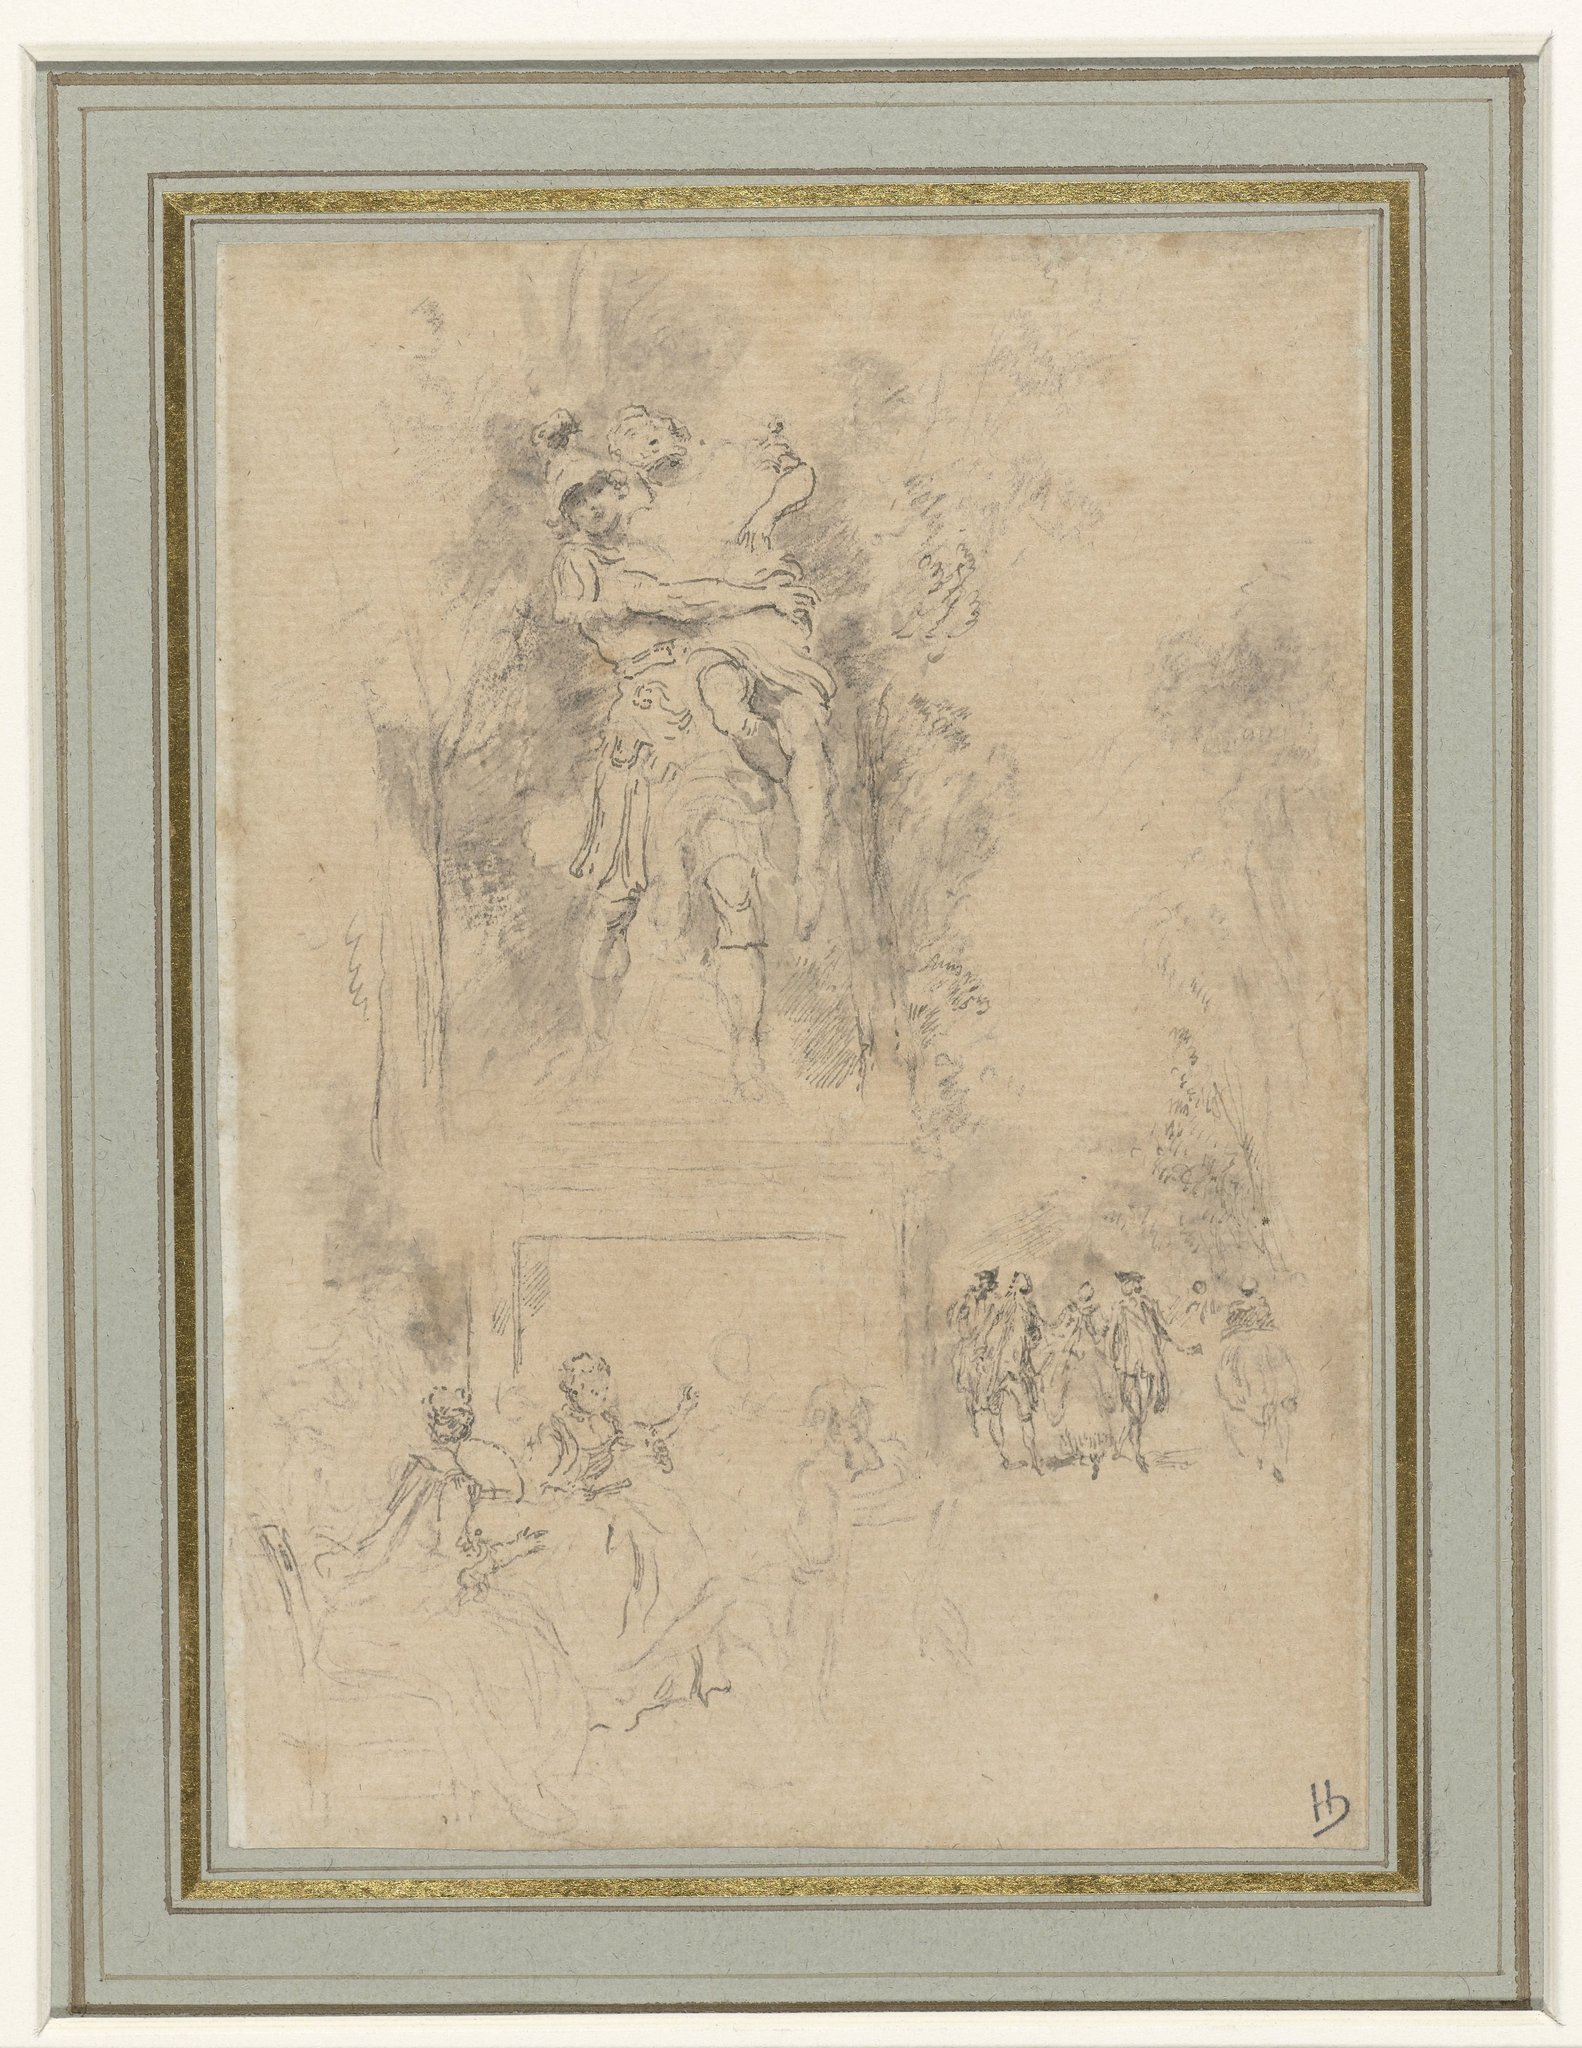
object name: drawing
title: De tuin van de Tuilerieën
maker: gabriel jacques de saint-aubin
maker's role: draughtsman, print maker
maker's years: 1724-1780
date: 1760-1780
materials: chalk, ink, paper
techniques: brush, pen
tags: public gardens, park (+ city(-scape) with figures, staffage), monument, statue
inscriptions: collector's mark, recto, lower right: Lugt 3604, collector's mark, verso, centre: Lugt 2228